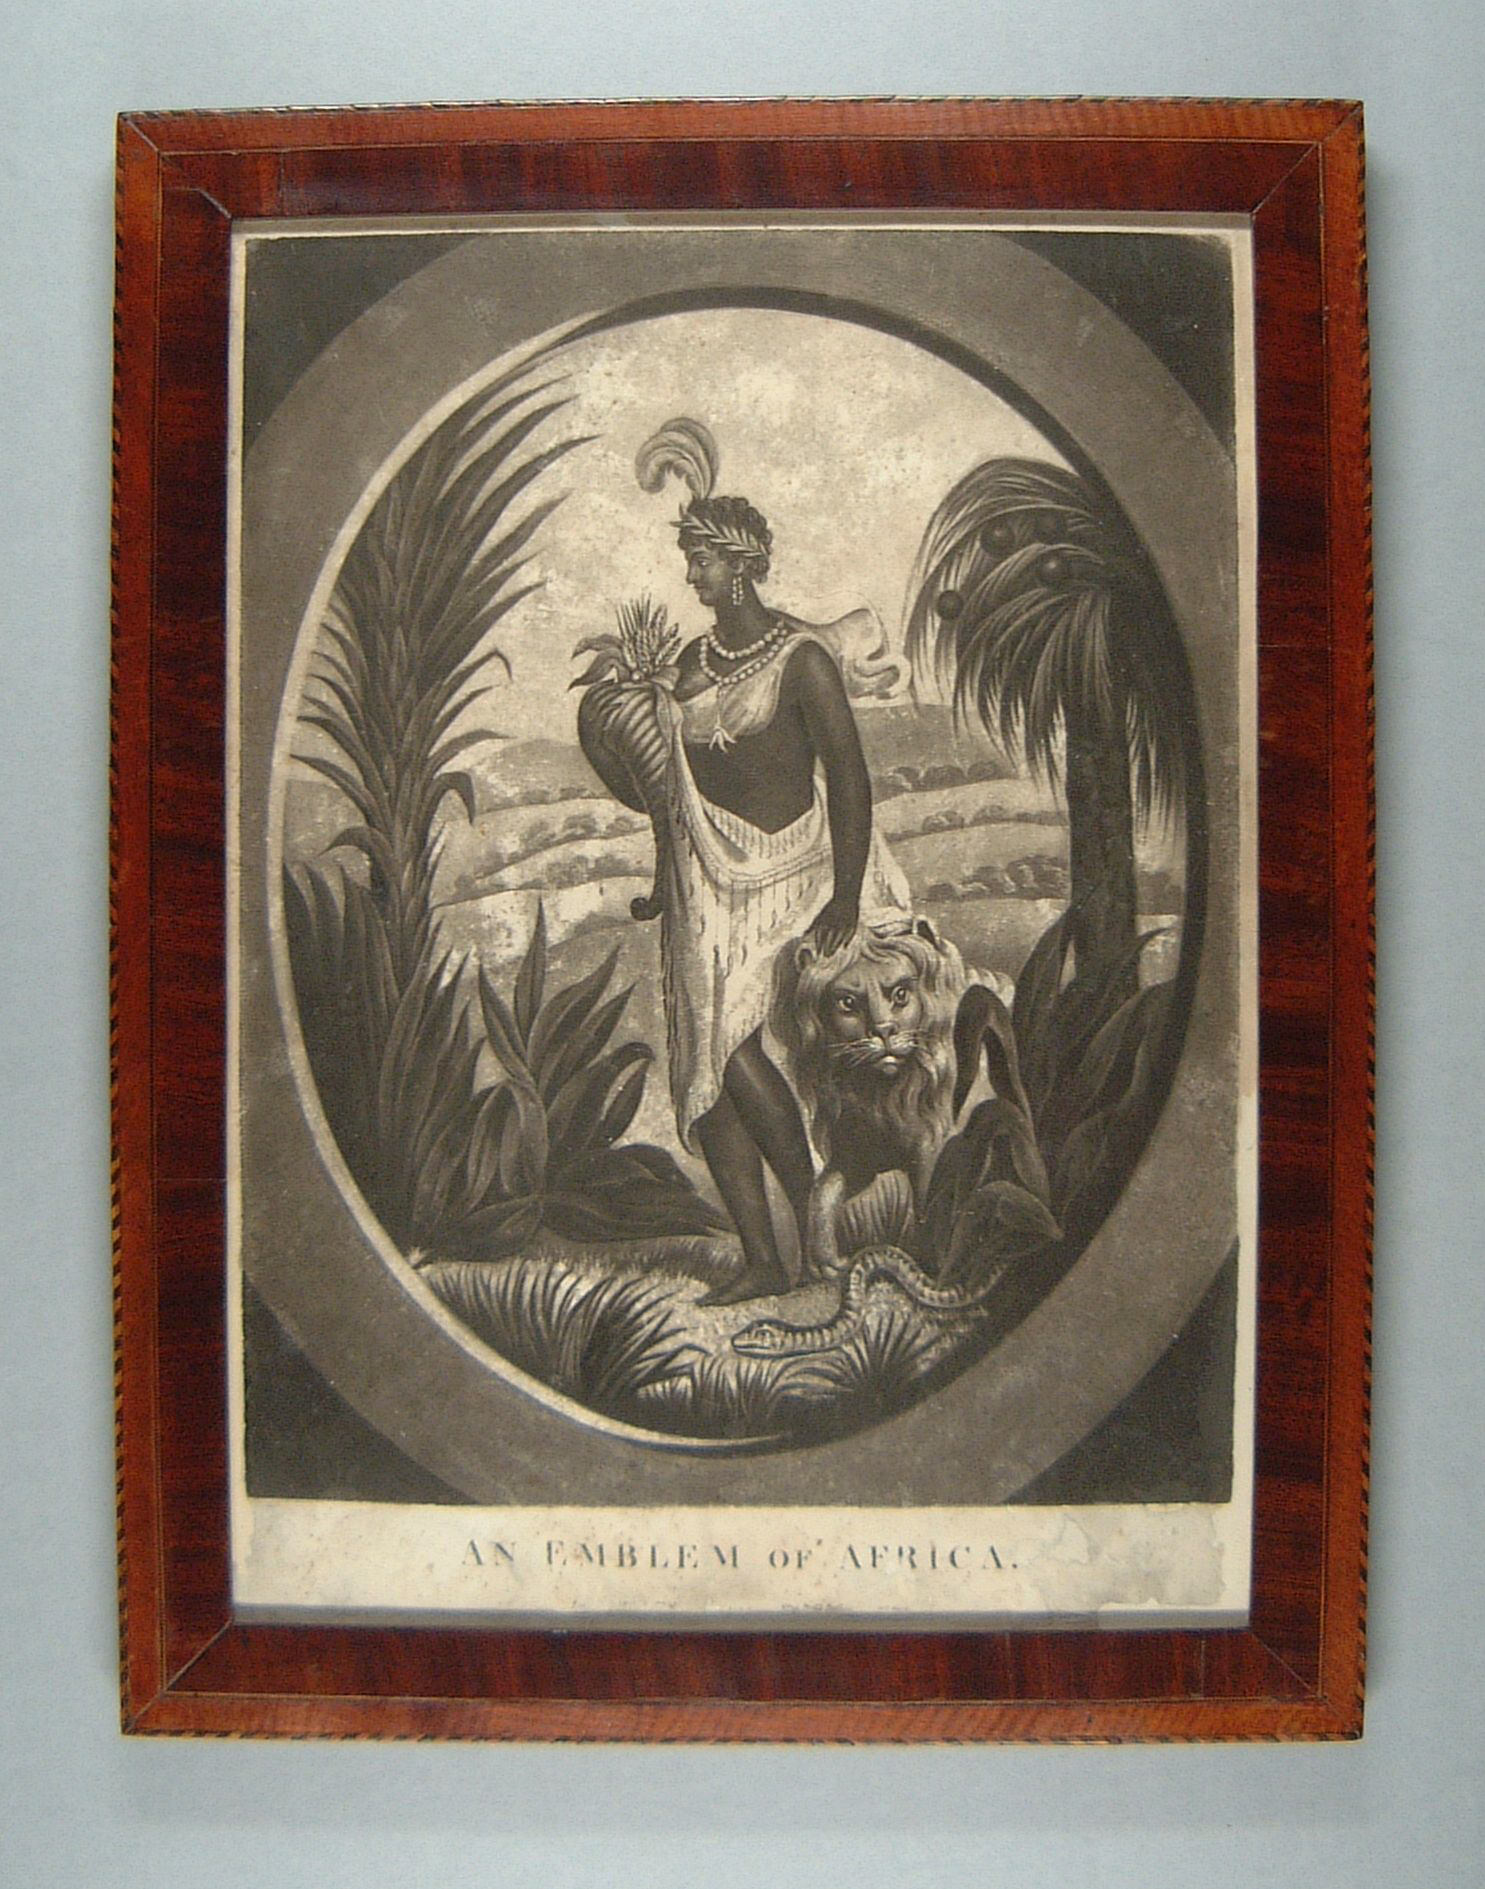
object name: print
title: Framed Print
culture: american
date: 1801-1810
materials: wood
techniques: veneering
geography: united states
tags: men,lions,snakes,plants